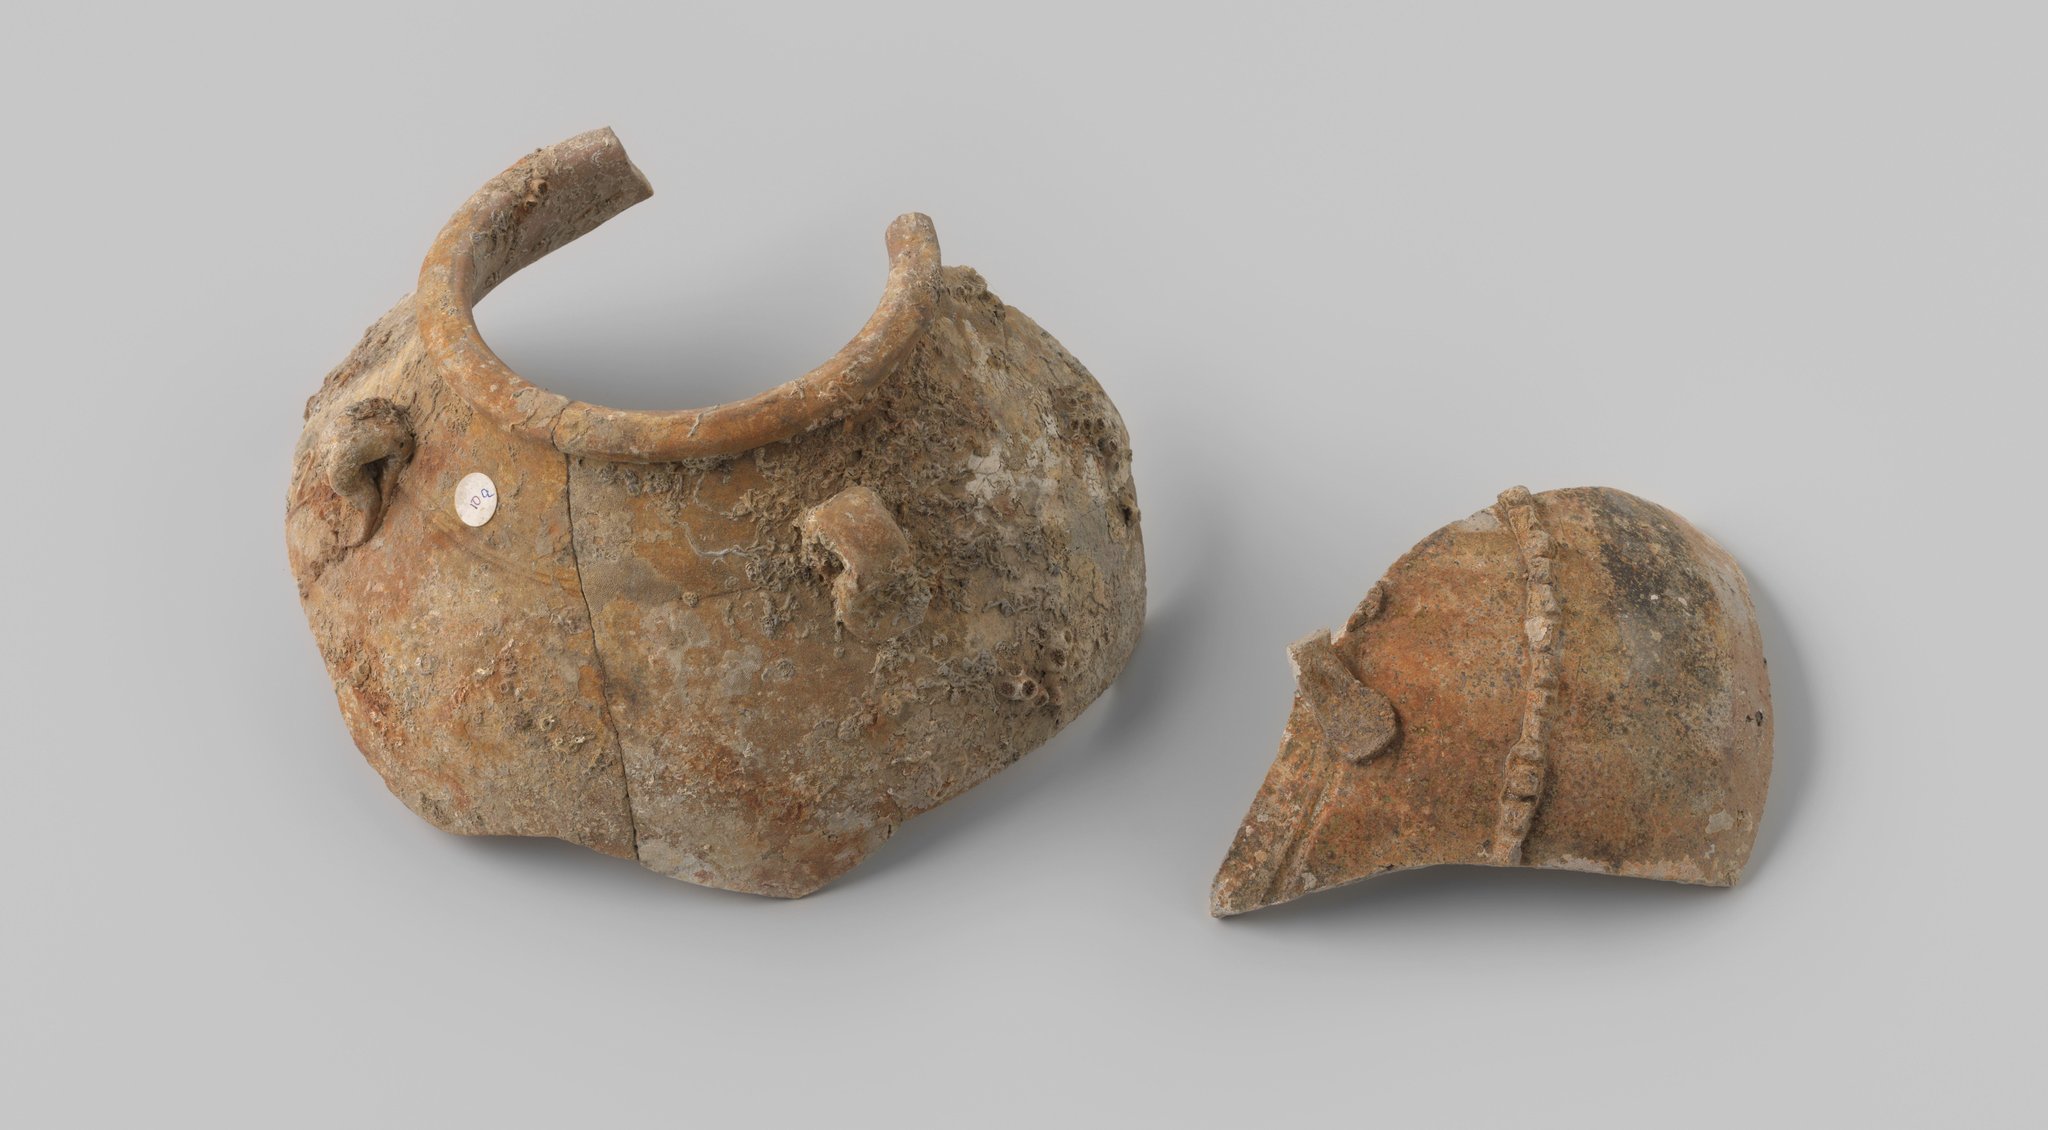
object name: martavaan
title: Scherven van martavanen uit V.O.C.-schip de 'Witte Leeuw'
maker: Anonymous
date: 1613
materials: porcelain, stoneware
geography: southeast asia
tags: verenigde oostindische compagnie, sint-helena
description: A jar. This jar has a short, straight, upright neck with a flattened, everted lip. The surface is burnt red-grey on the outside, which jas not been glazed. The glaze drippings on the inside of the lip and neck are partially worn off, leaving a grey discolouration of the surface. On the outside, the surface is partially glazed, and partially discoloured. There is an applied band of pearls, 3 cm beneath the ears.